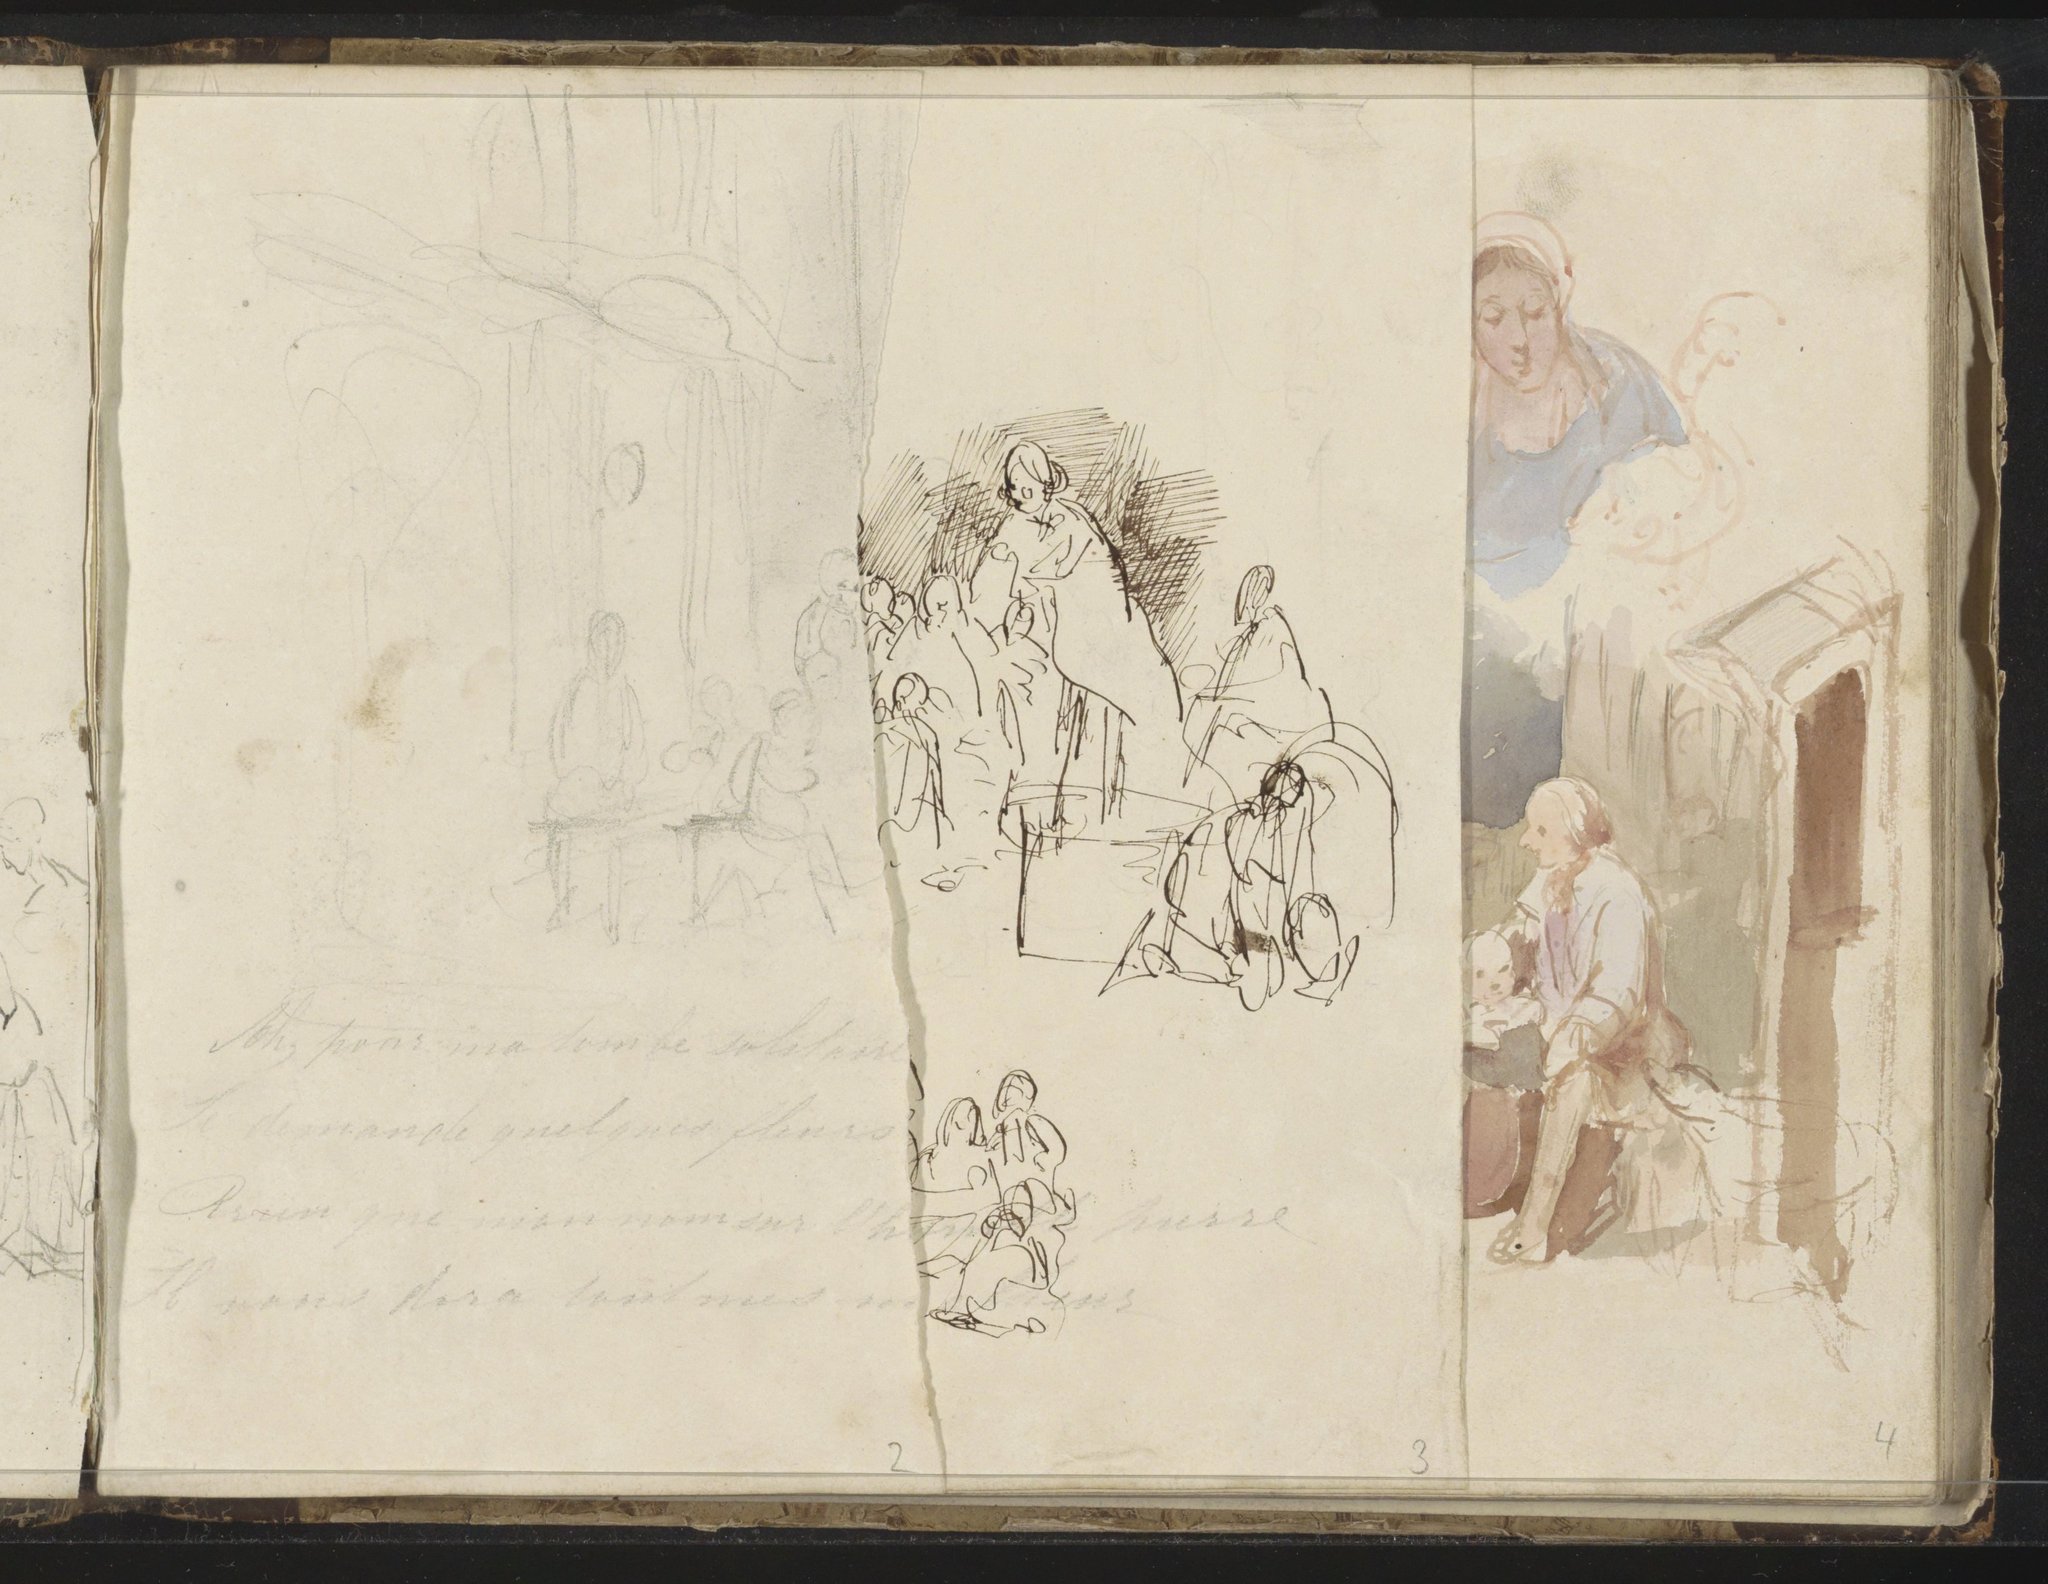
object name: sketchbook leaf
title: Figuren aan een tafel bij een muur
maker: willem hendrik schmidt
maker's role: draughtsman, painter, print maker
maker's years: 1809-1849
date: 1819-1849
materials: paper, pencil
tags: table, architecture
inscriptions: annotation: ‘Mes pa[...]s ma tombe solitaire/ Il demandé quelques fleurs/ [...]’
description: Het blad is grotendeels uit het schetsboek gescheurd.